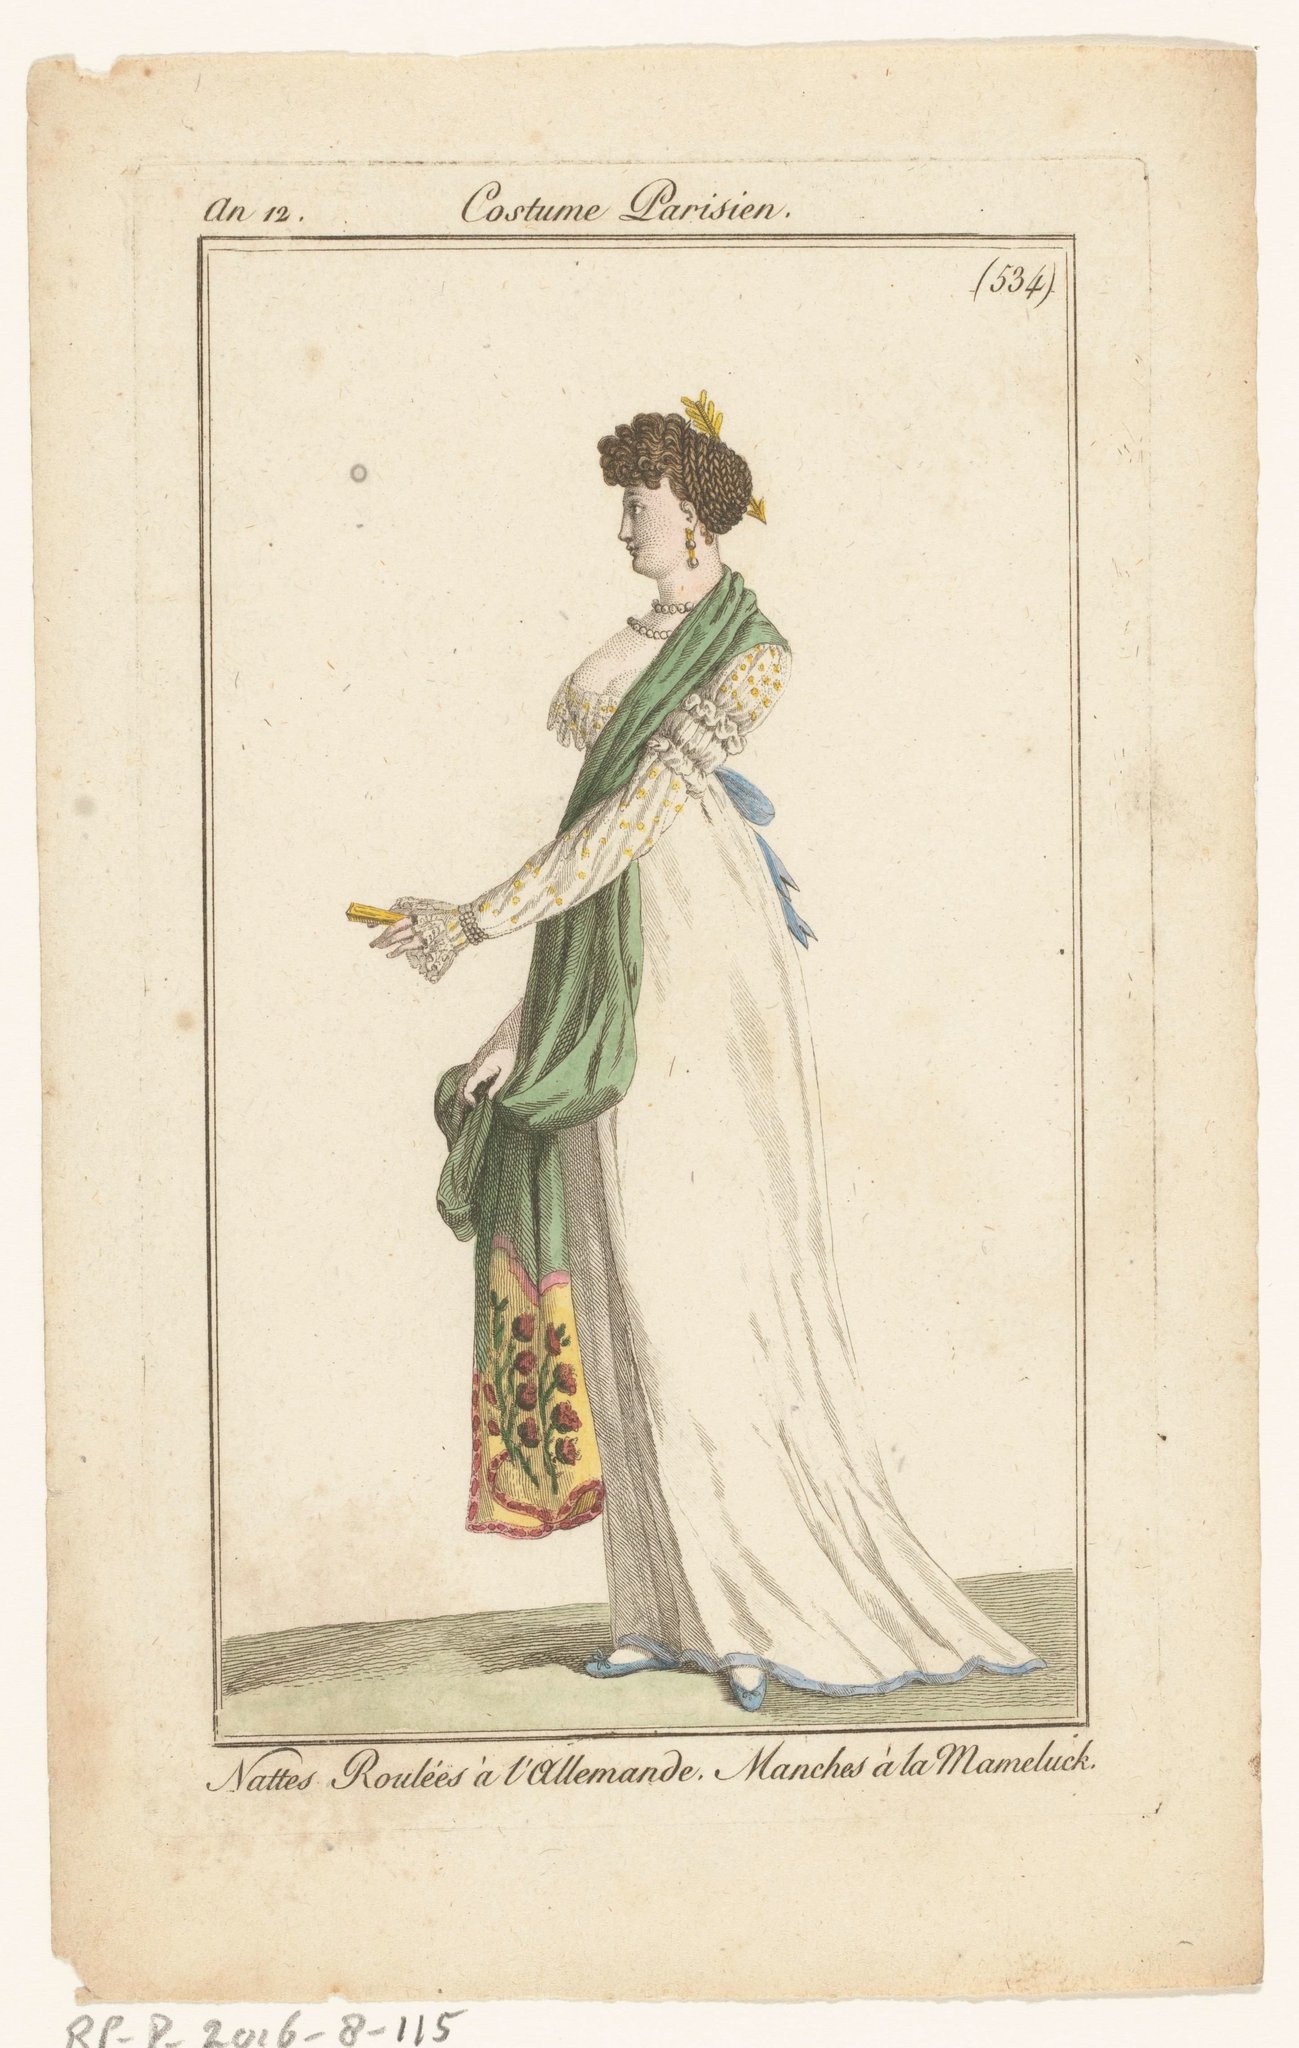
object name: fashion print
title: Journal des Dames et des modes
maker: Anonymous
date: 1803-1804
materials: paper, ink, watercolor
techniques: etching, hand coloring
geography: france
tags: fashion plates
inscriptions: collector's mark: Lugt 2228